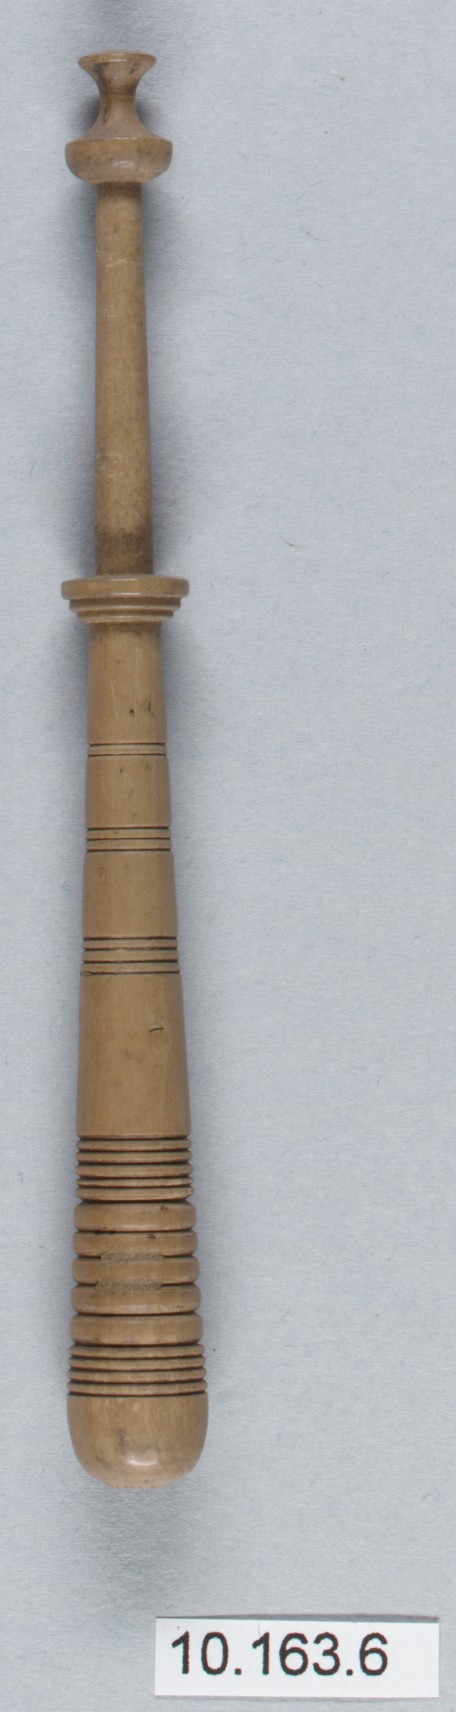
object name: bobbin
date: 1801-1900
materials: wood